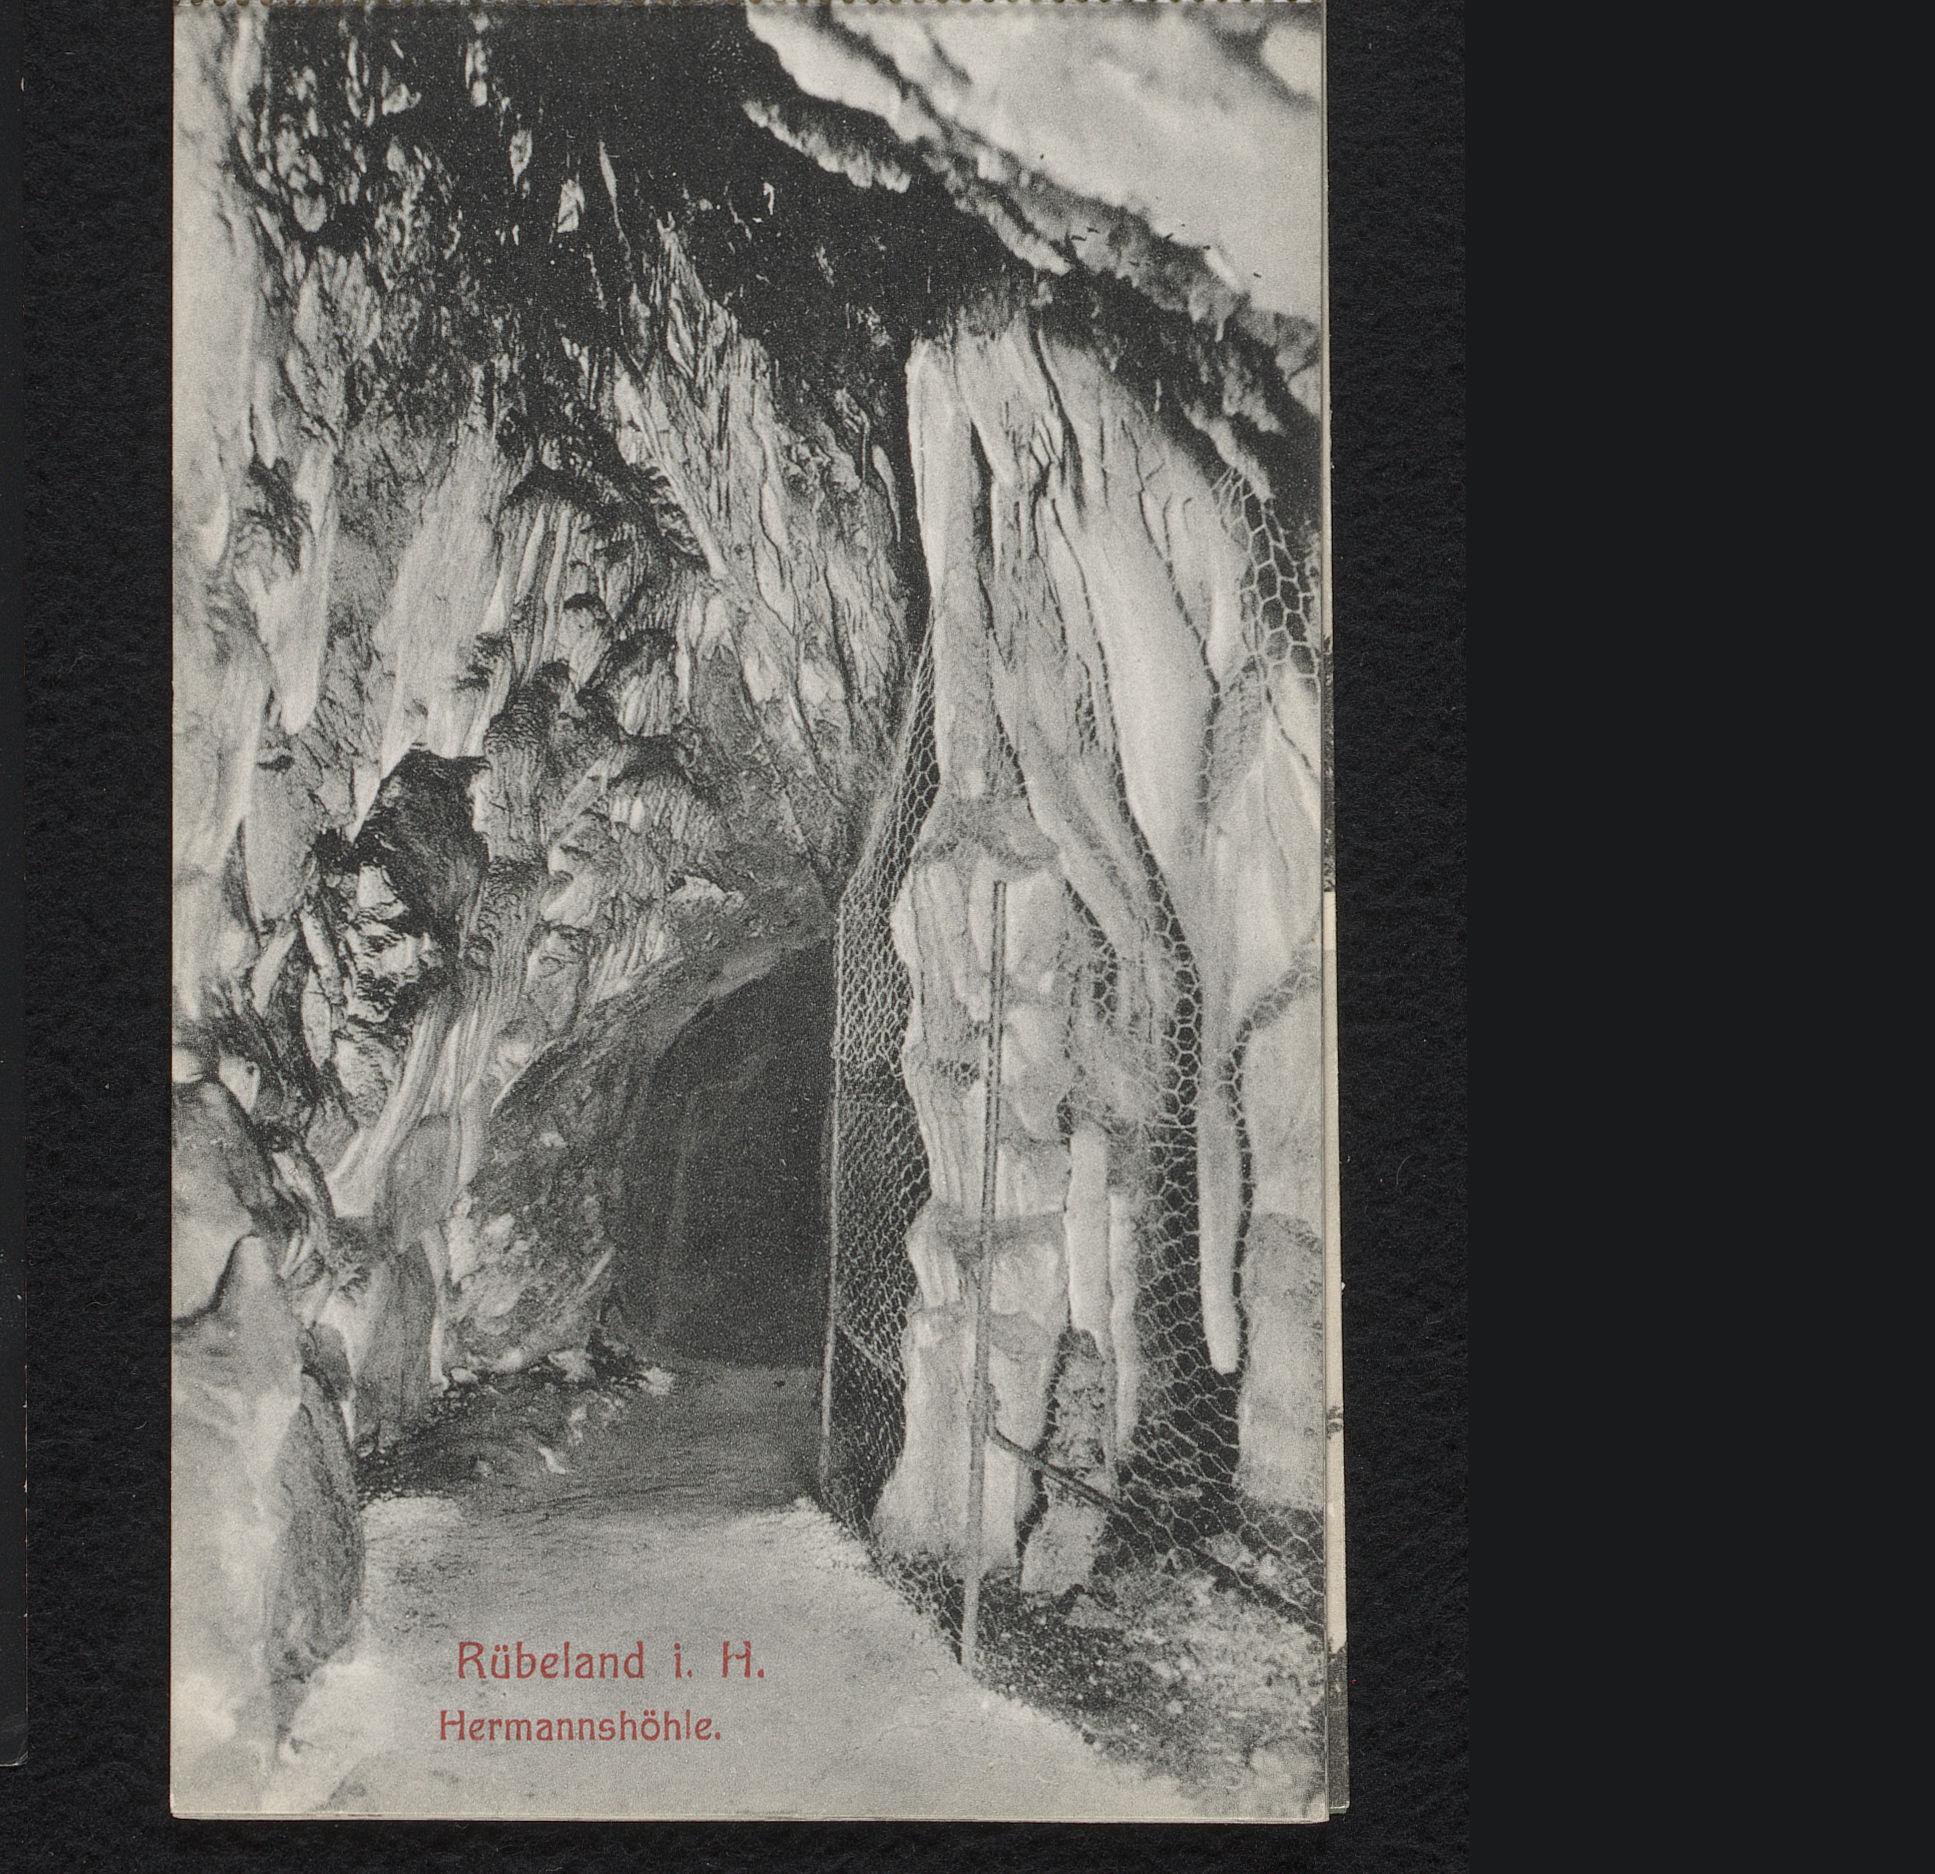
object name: ansichtkaart, prentbriefkaart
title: Rübeland i. H. Hermannshöhle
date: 1907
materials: cardboard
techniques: photograph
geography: rübeland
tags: stalactitic cave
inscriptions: date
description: Prentbriefkaart maakt deel uit van een album.